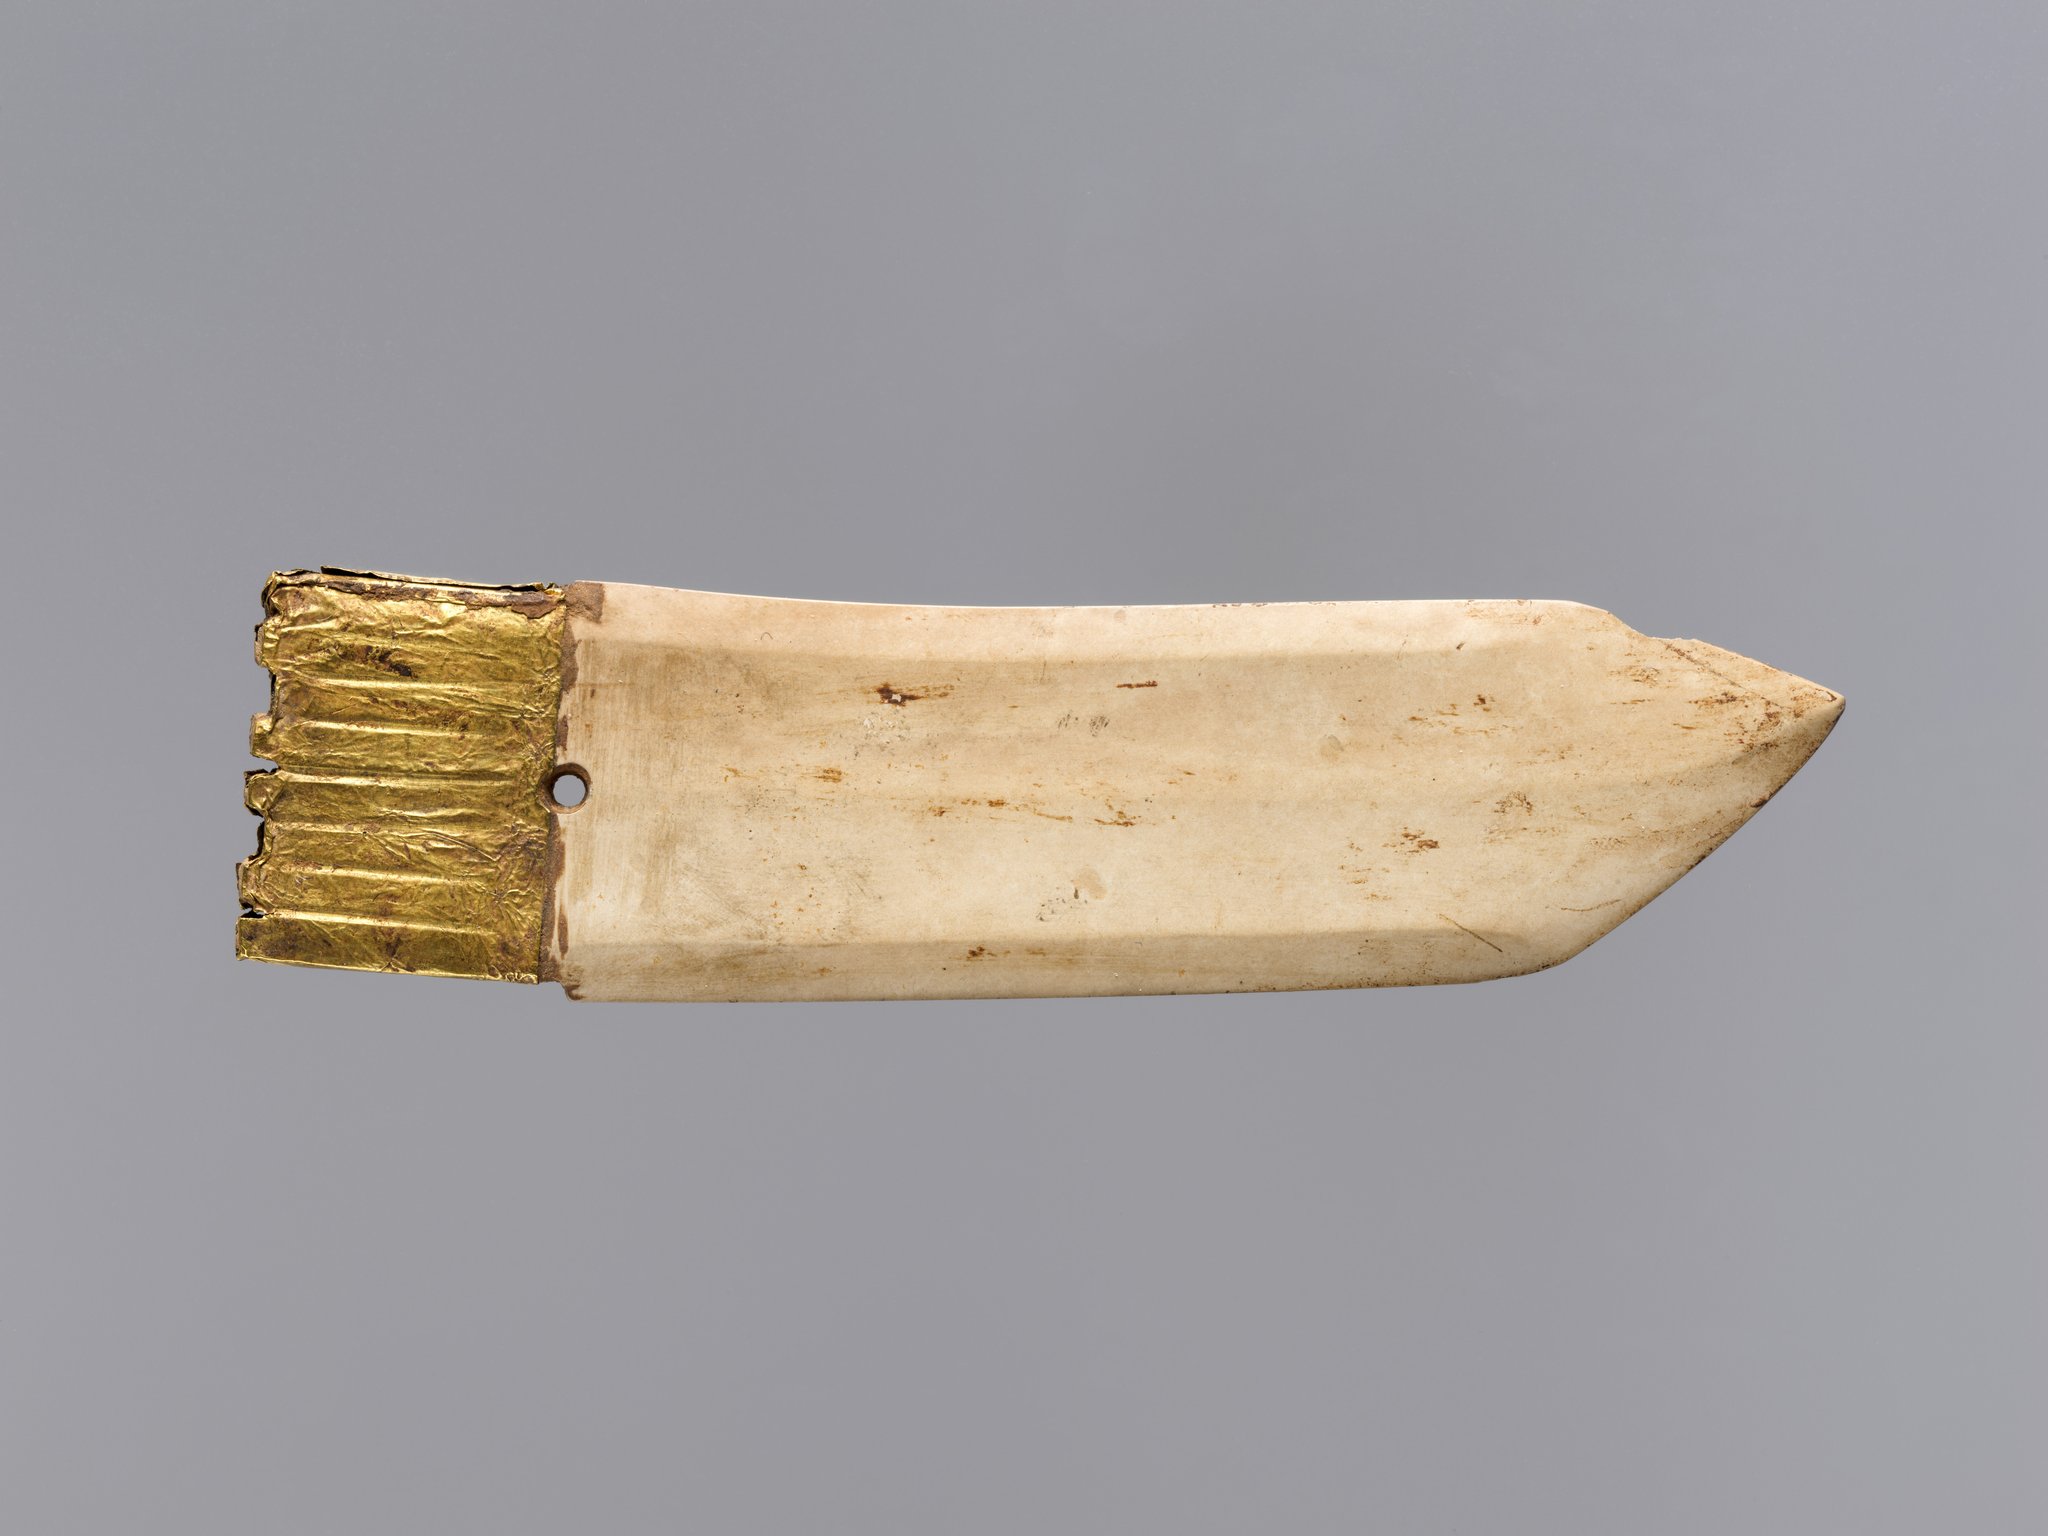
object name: dagger ax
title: Ceremonial dagger-ax (Ge)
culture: chinese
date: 1300-1001 BCE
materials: gold, jade